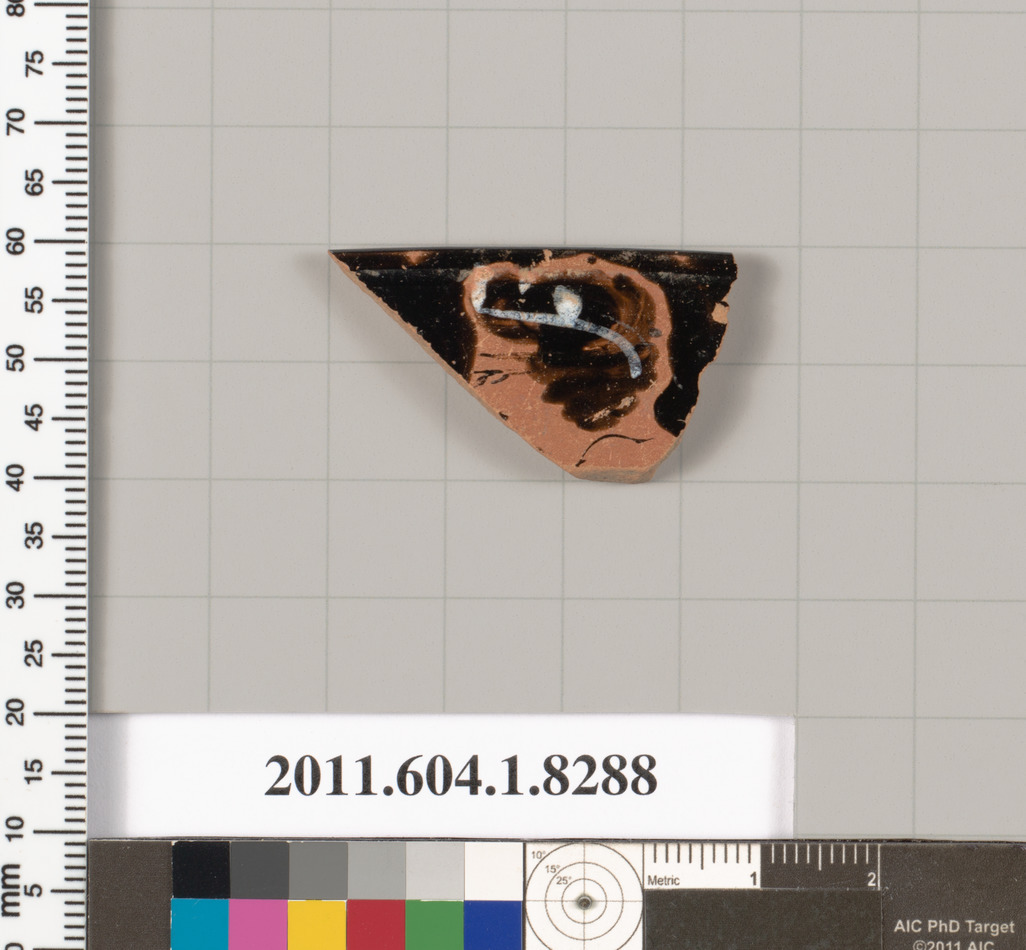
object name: kylix fragment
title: Terracotta rim fragment of a kylix (drinking cup)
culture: greek, attic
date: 400-376 BCE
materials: terracotta